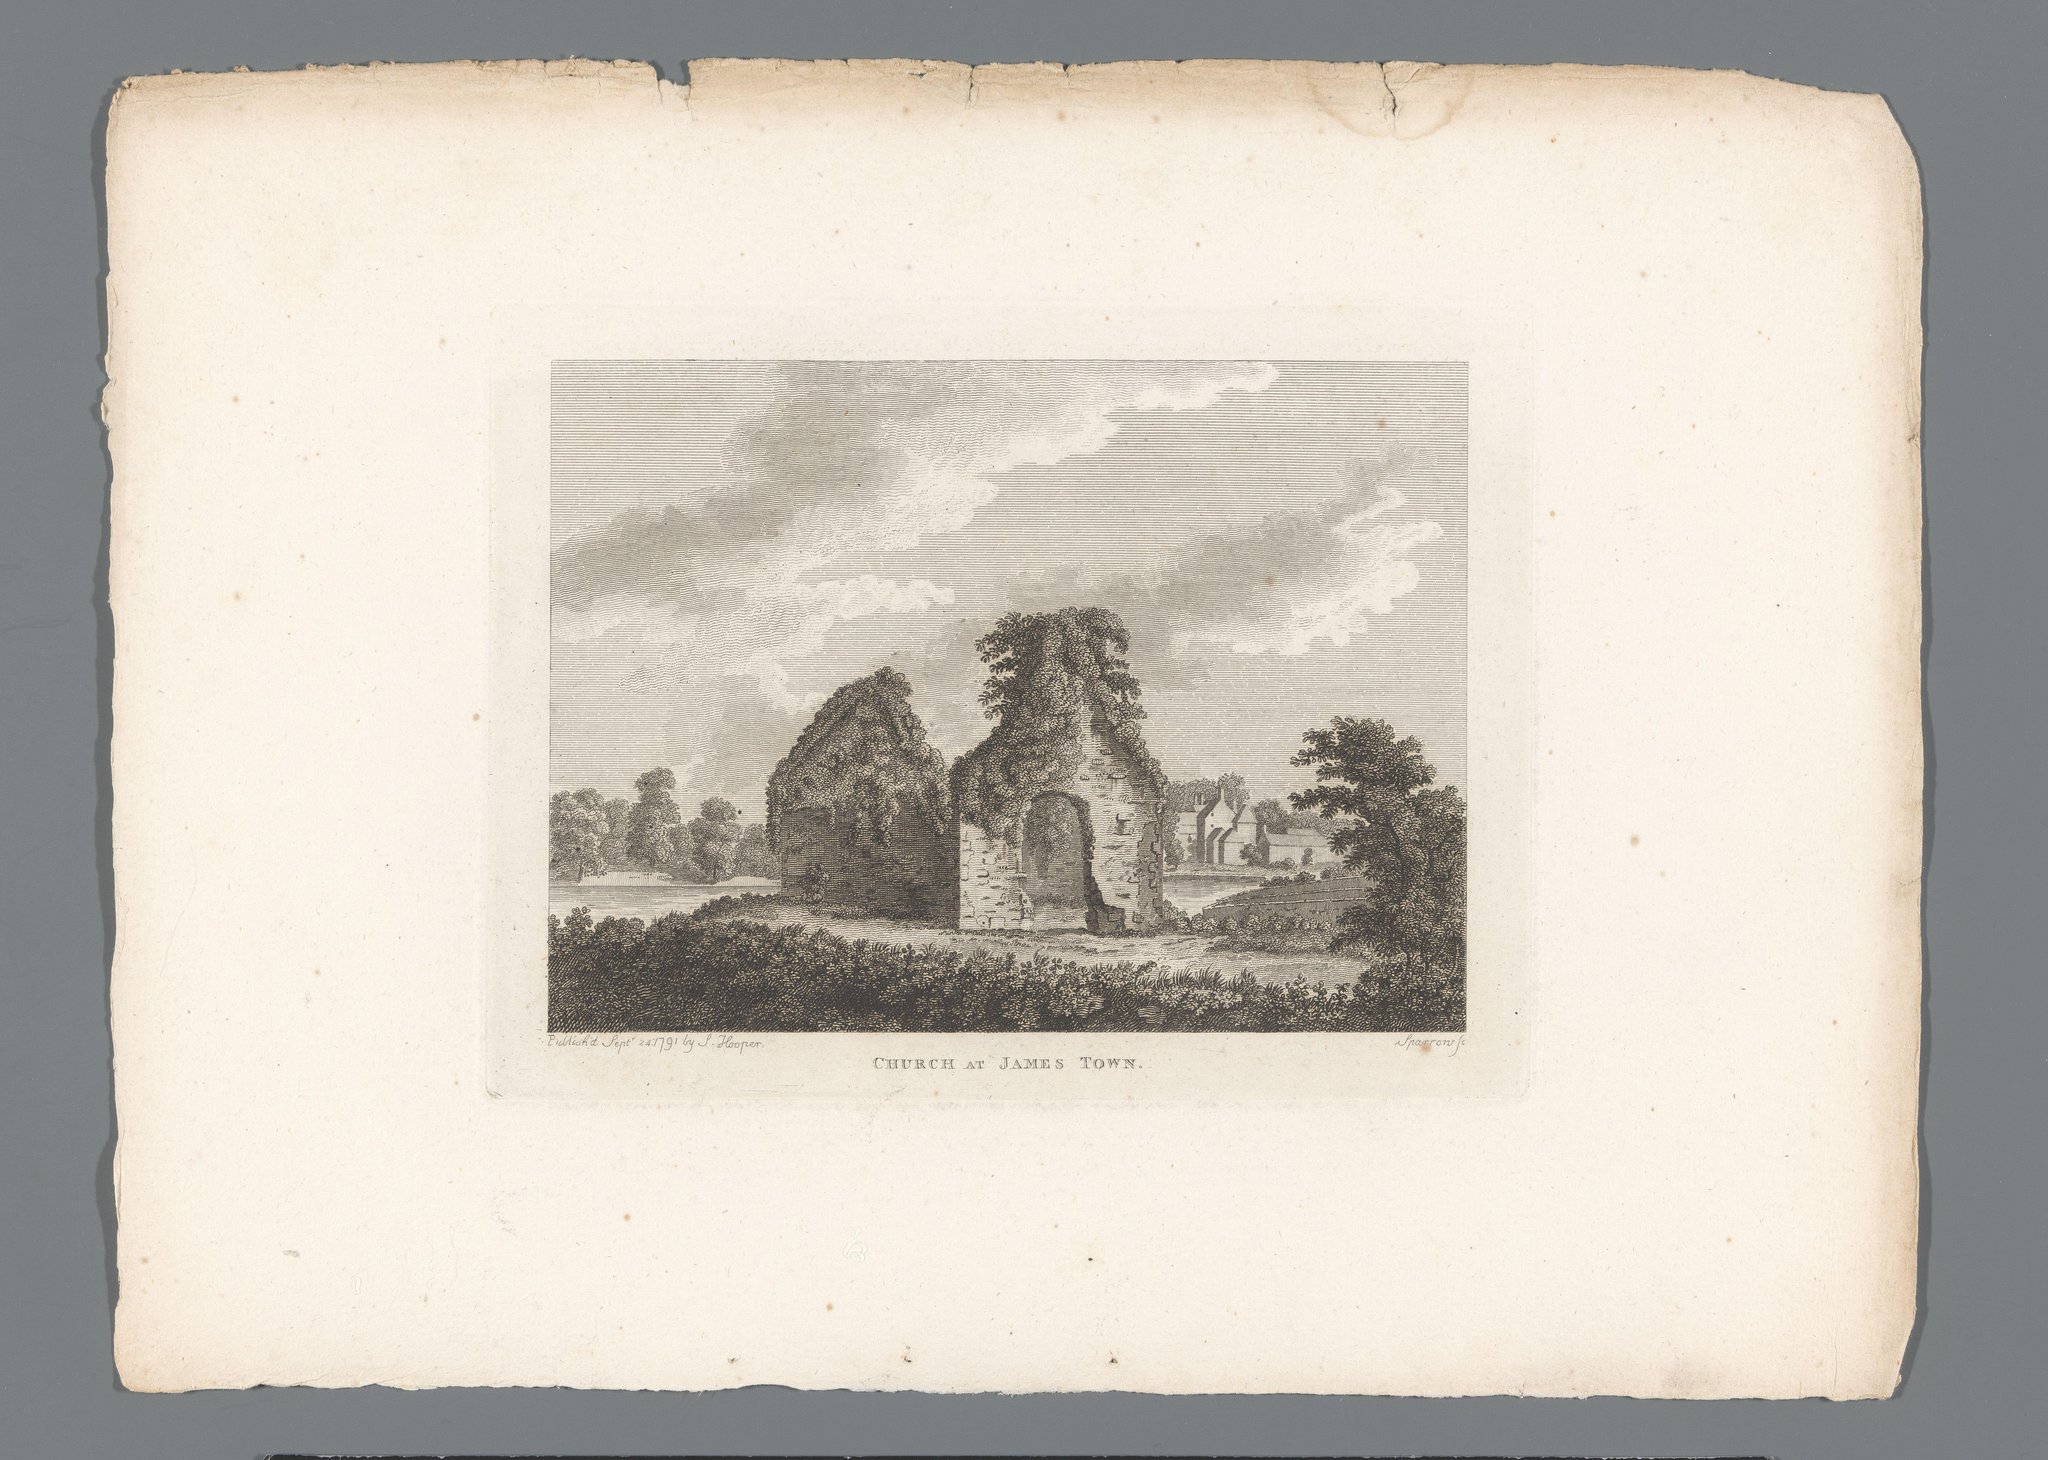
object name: print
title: Church at James Town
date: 1791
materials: paper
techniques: etching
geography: london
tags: landscape with ruins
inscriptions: date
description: Prent verschenen in: Grose, Francis. Antiquities of Ireland. Londen: S. Hooper, 1809, dl. 2.